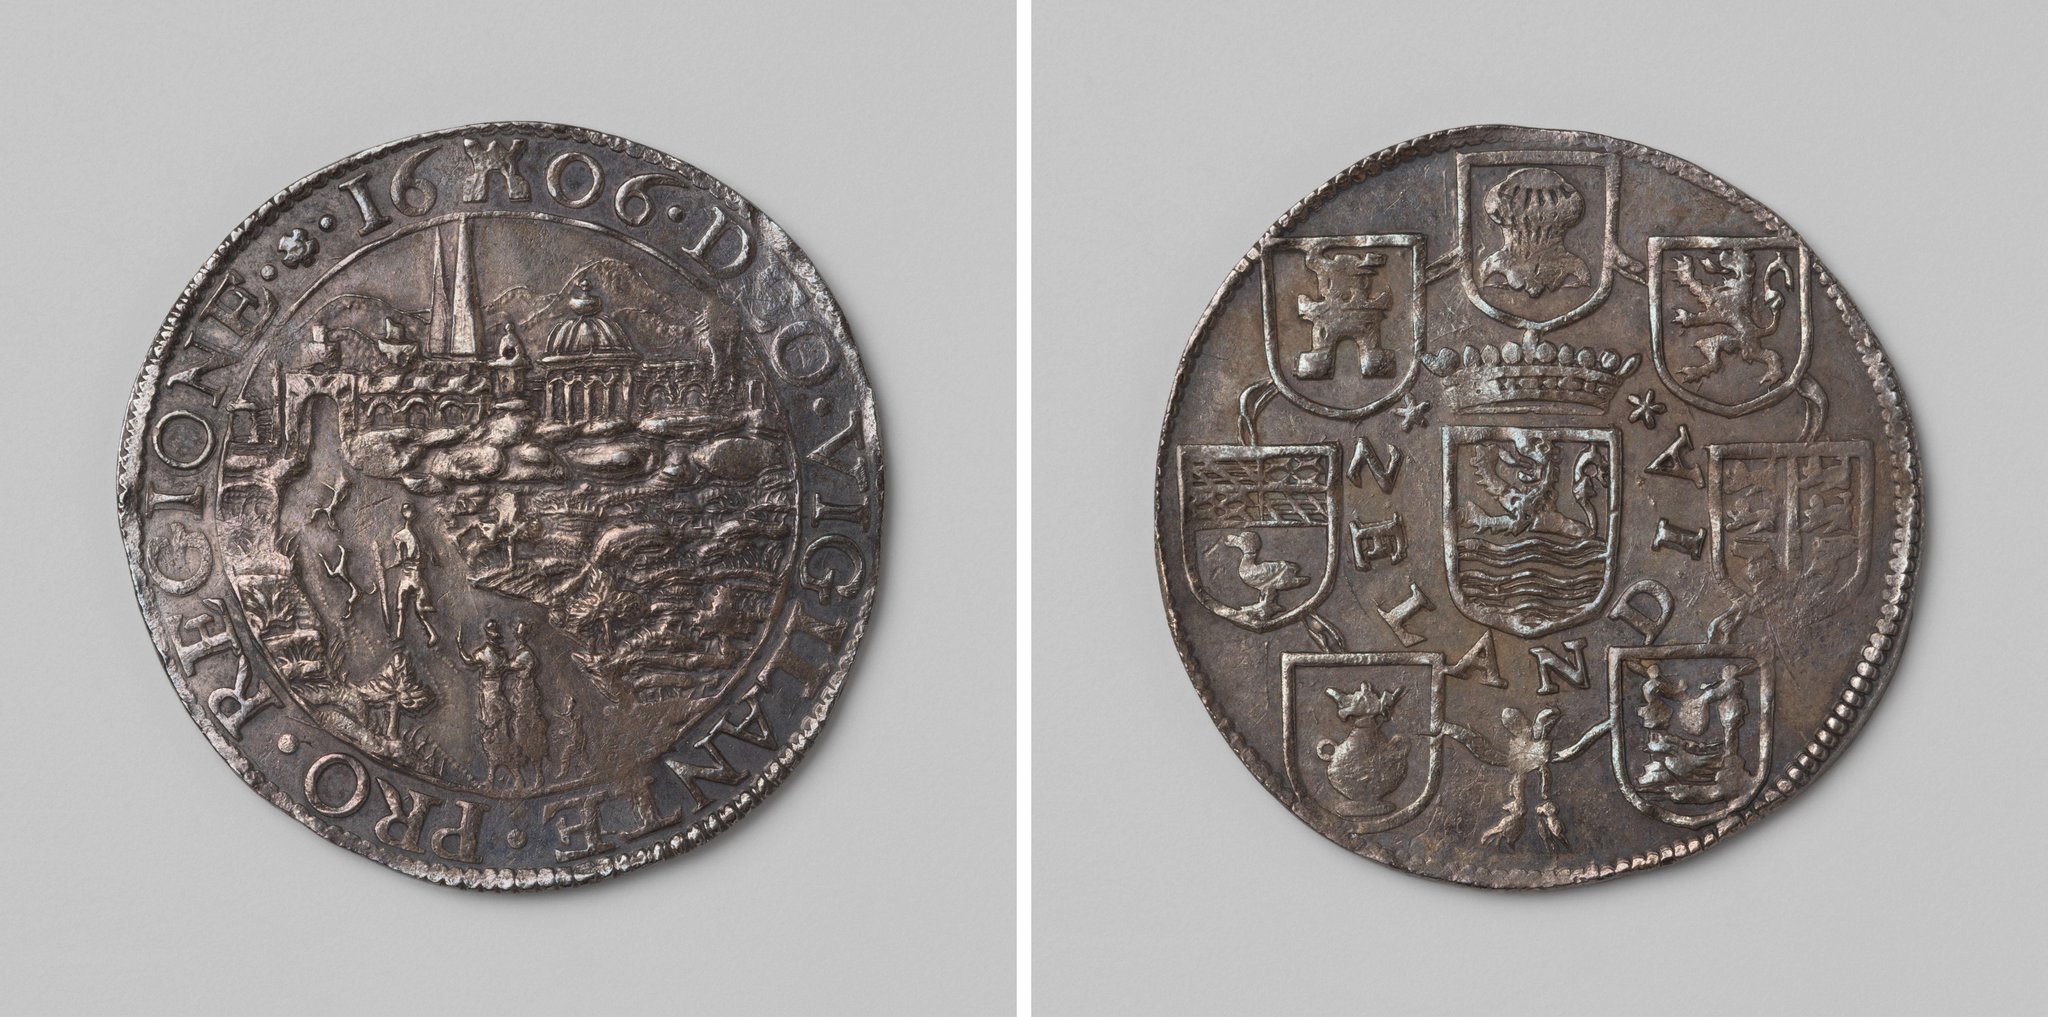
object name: jeton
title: Goddelijke bijstand aan de opstandelingen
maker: Anonymous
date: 1606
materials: silver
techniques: striking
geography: middelburg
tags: zeeland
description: Zilveren penning. Voorzijde: drukke weg leidend naar stad binnen omschrift. Keerzijde: gekroond wapenschild binnen omschrift en rand van zeven door lint verbonden wapenschilden